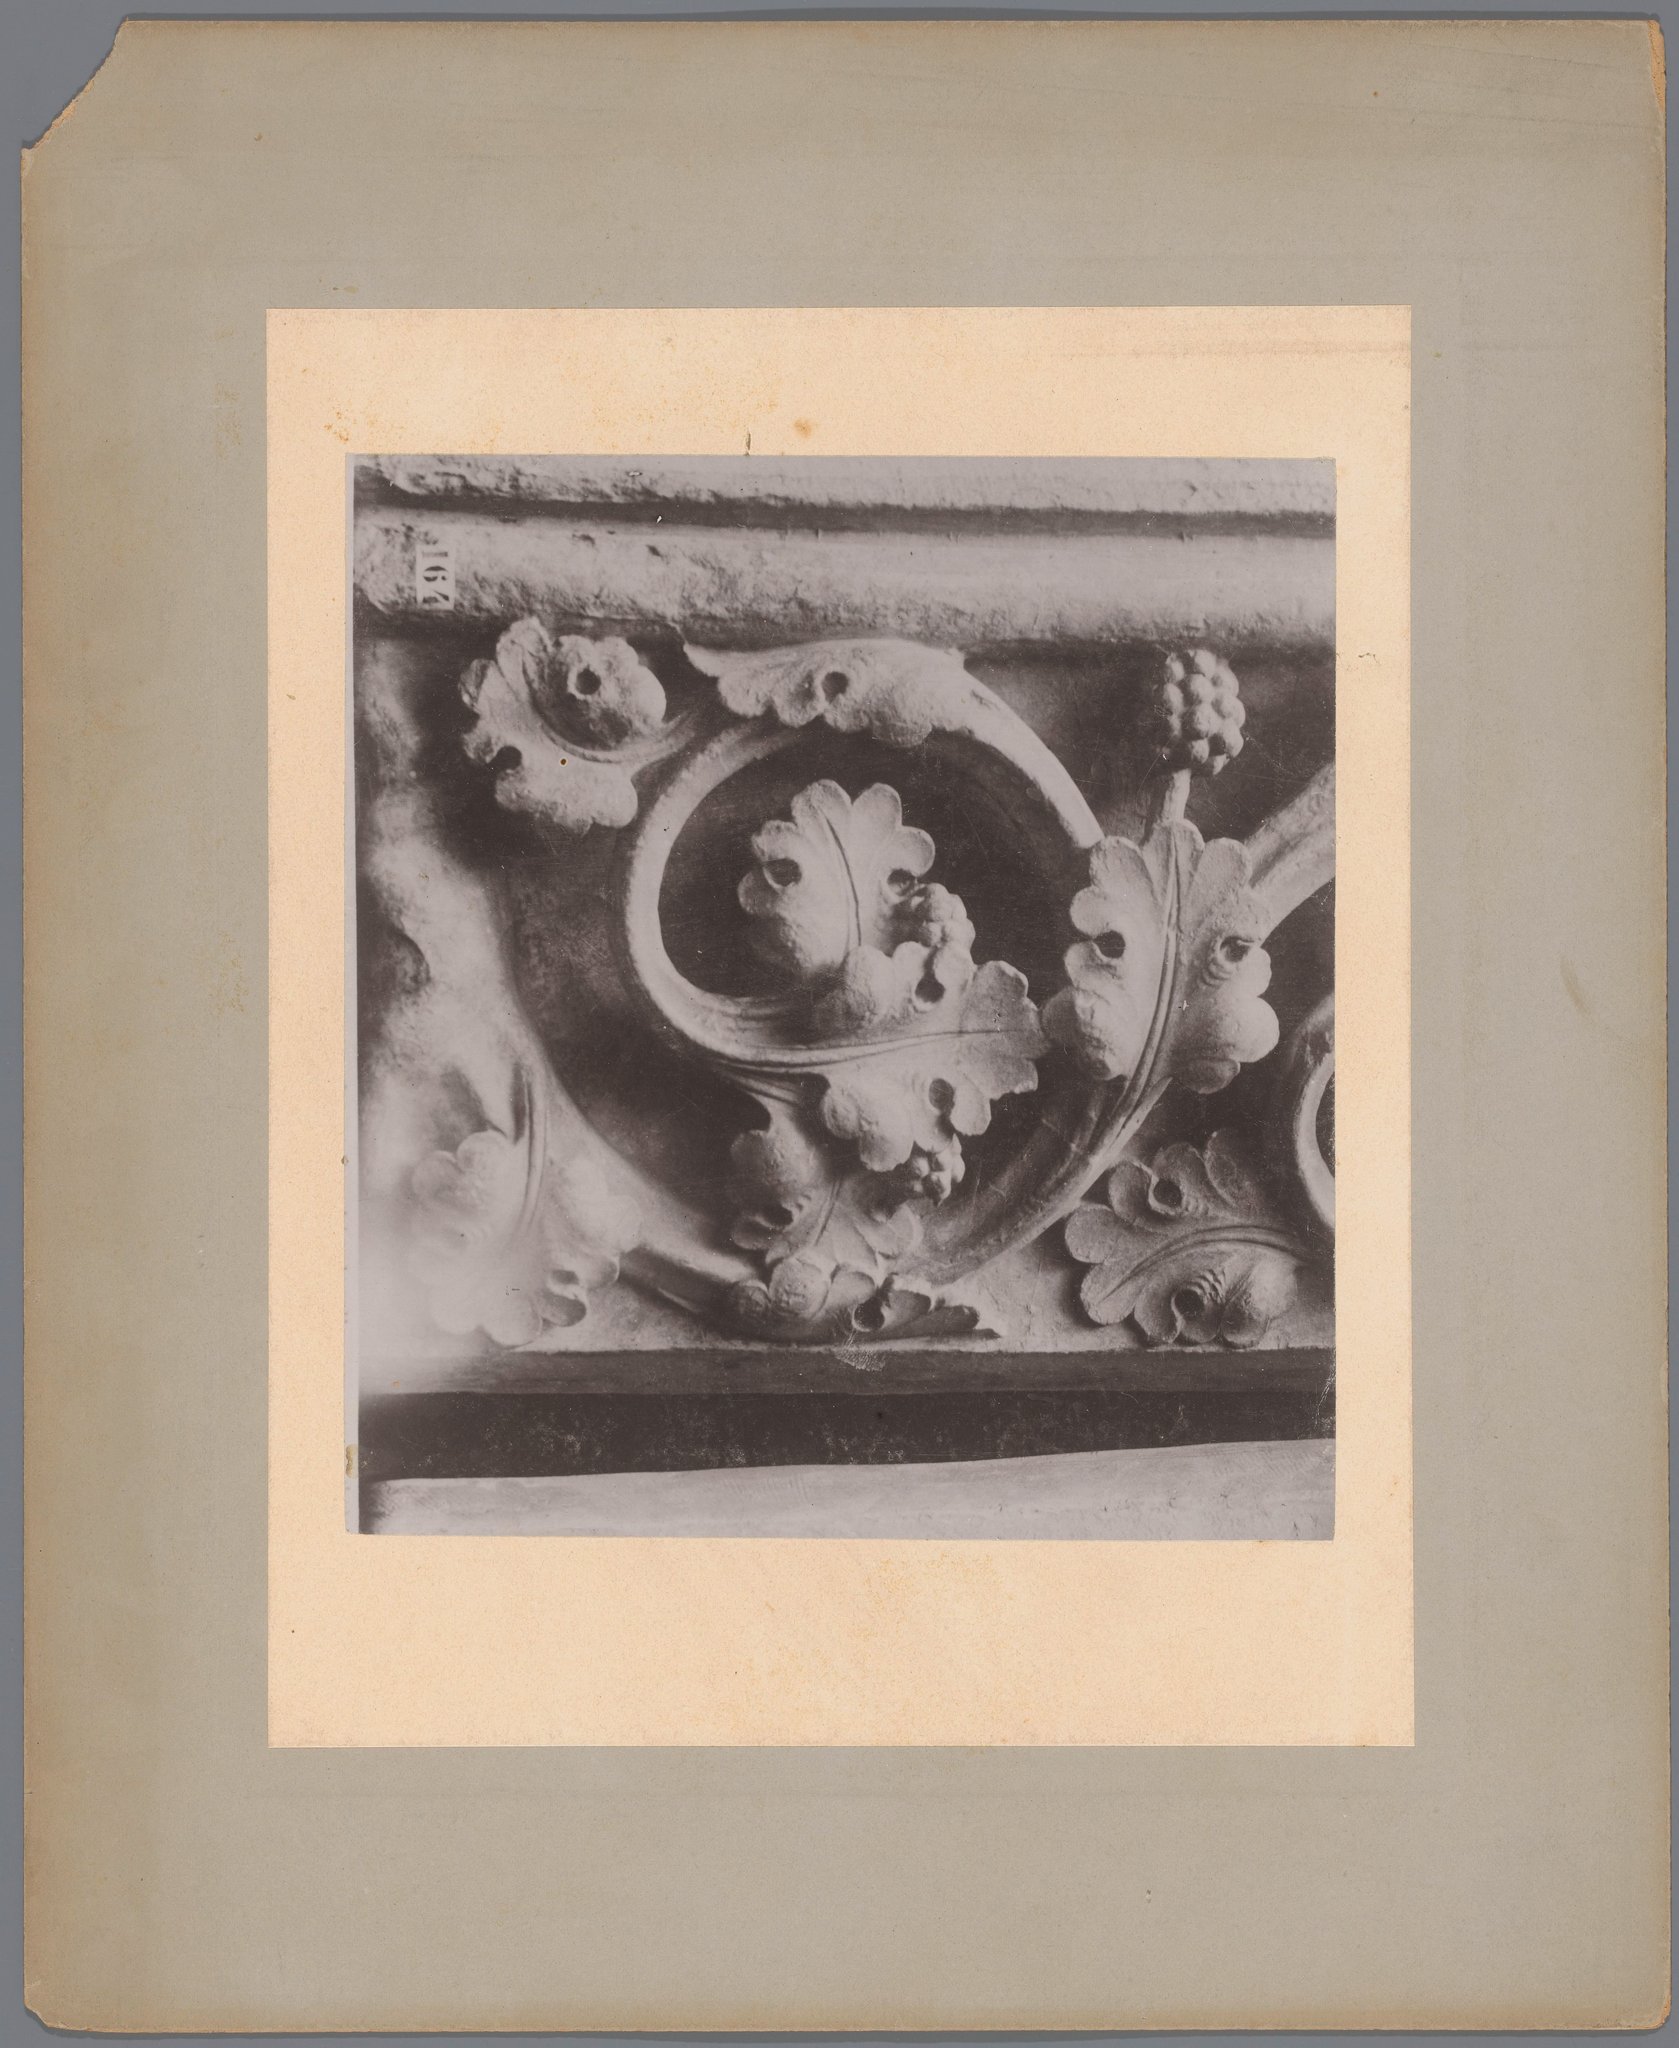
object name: photograph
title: Afgietsel van een detail van een archivolt versierd met rankwerk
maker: Anonymous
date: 1880-1940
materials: paper, cardboard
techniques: collodion silver print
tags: arch, archivolt ~ architecture, trees: oak (+ leaves, putting forth leaves)